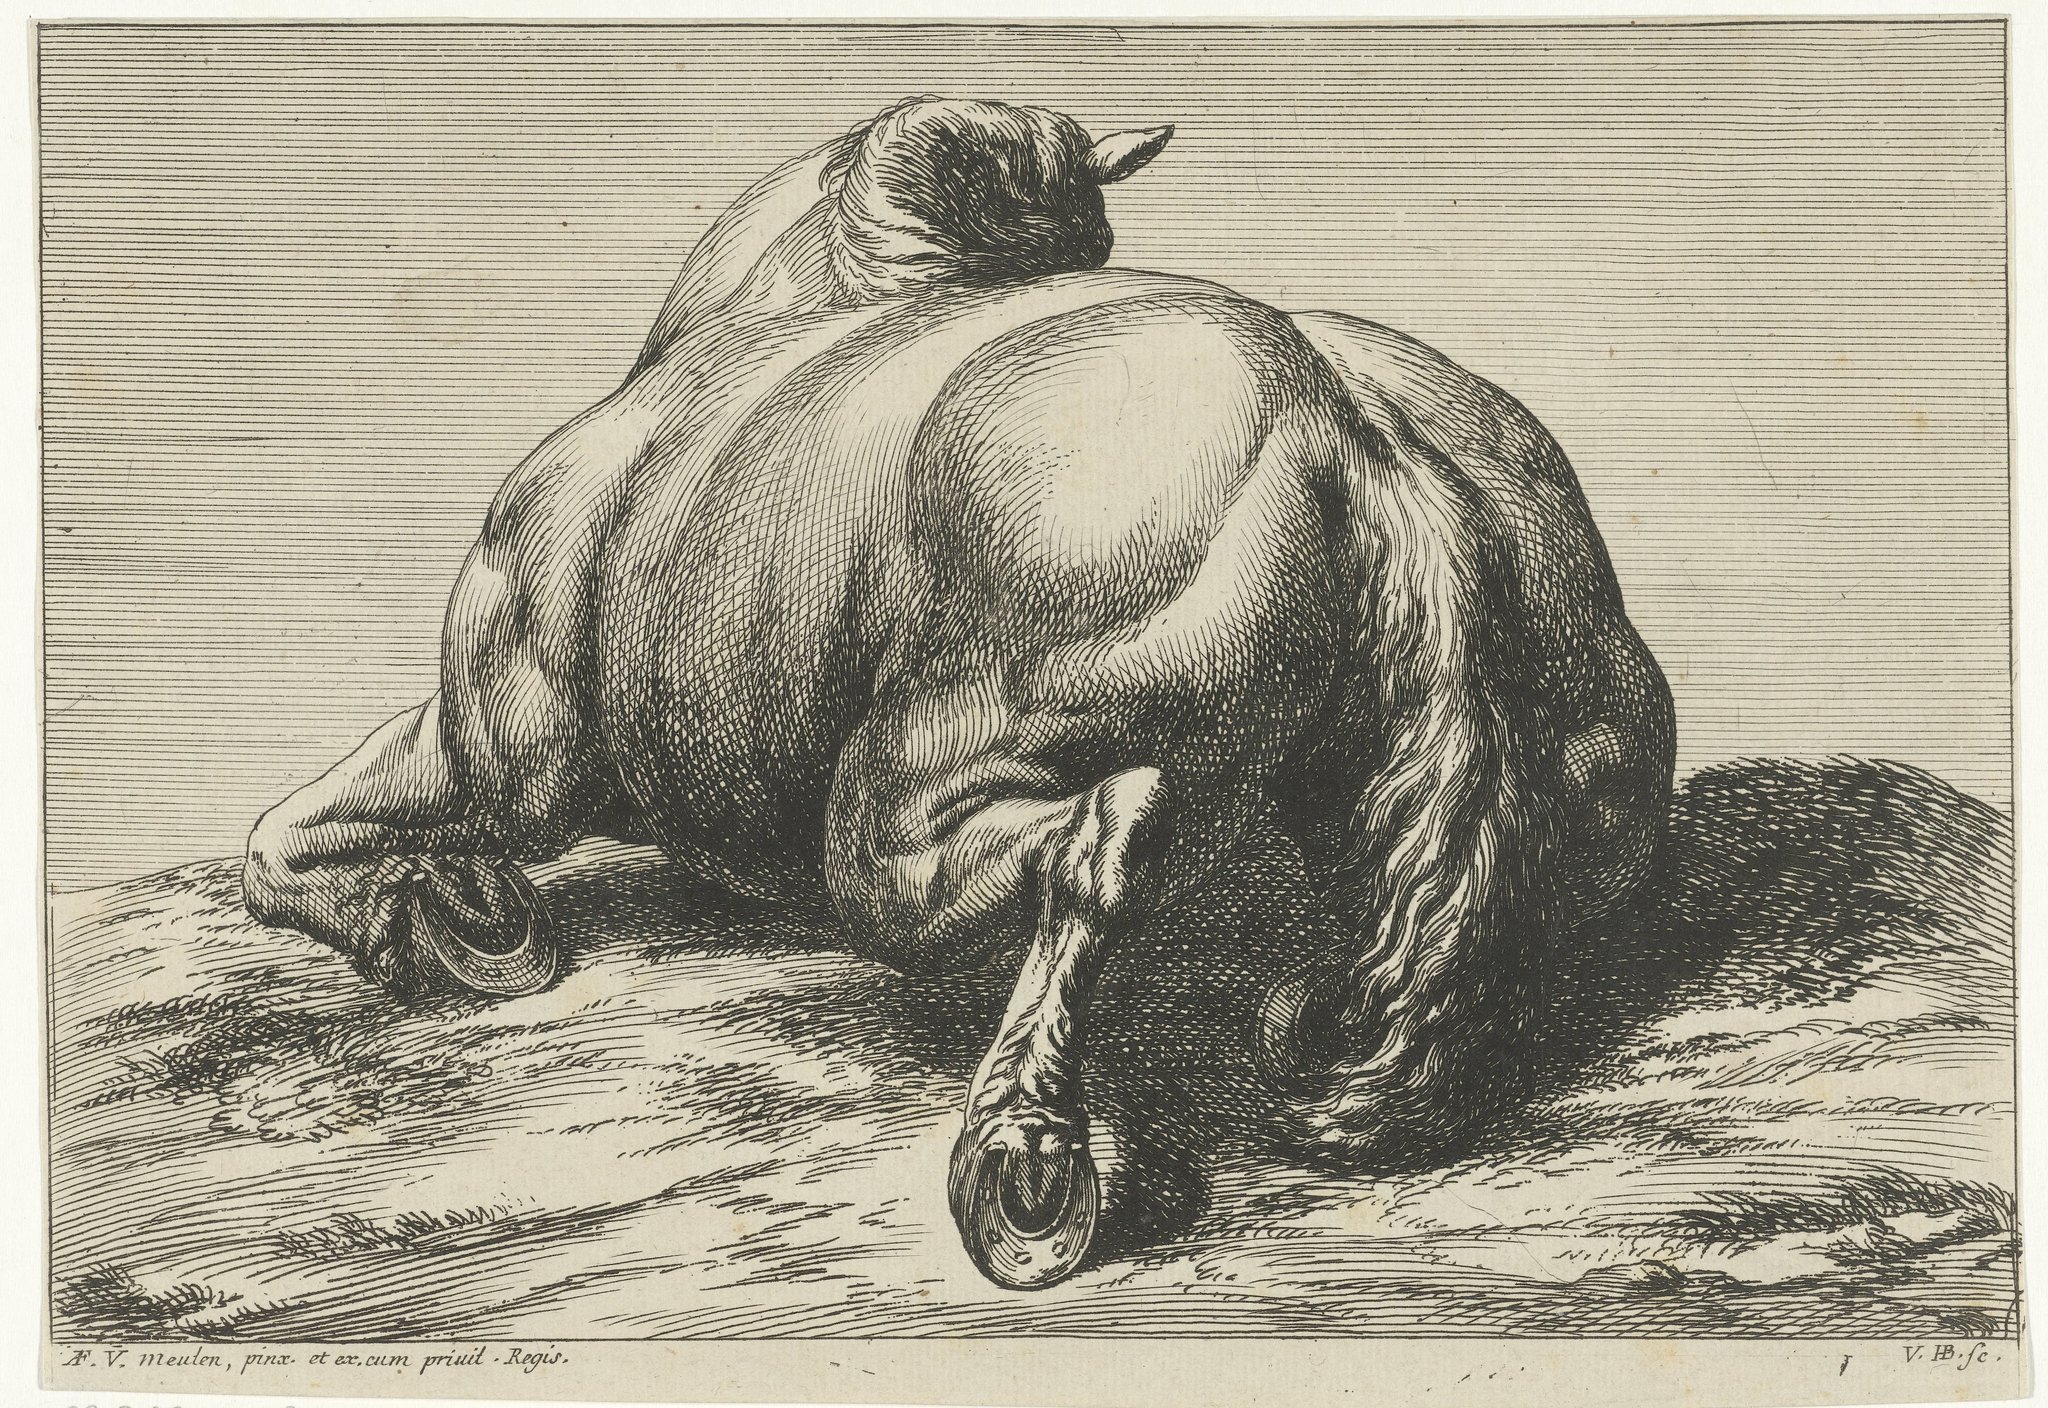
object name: print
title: Gesneuvelde paarden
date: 1674-1733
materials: paper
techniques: engraving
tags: horse (+ dying animal; death of animal; dead animal)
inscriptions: collector's mark: Lugt 2228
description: Op de buik liggend paard van achter gezien.